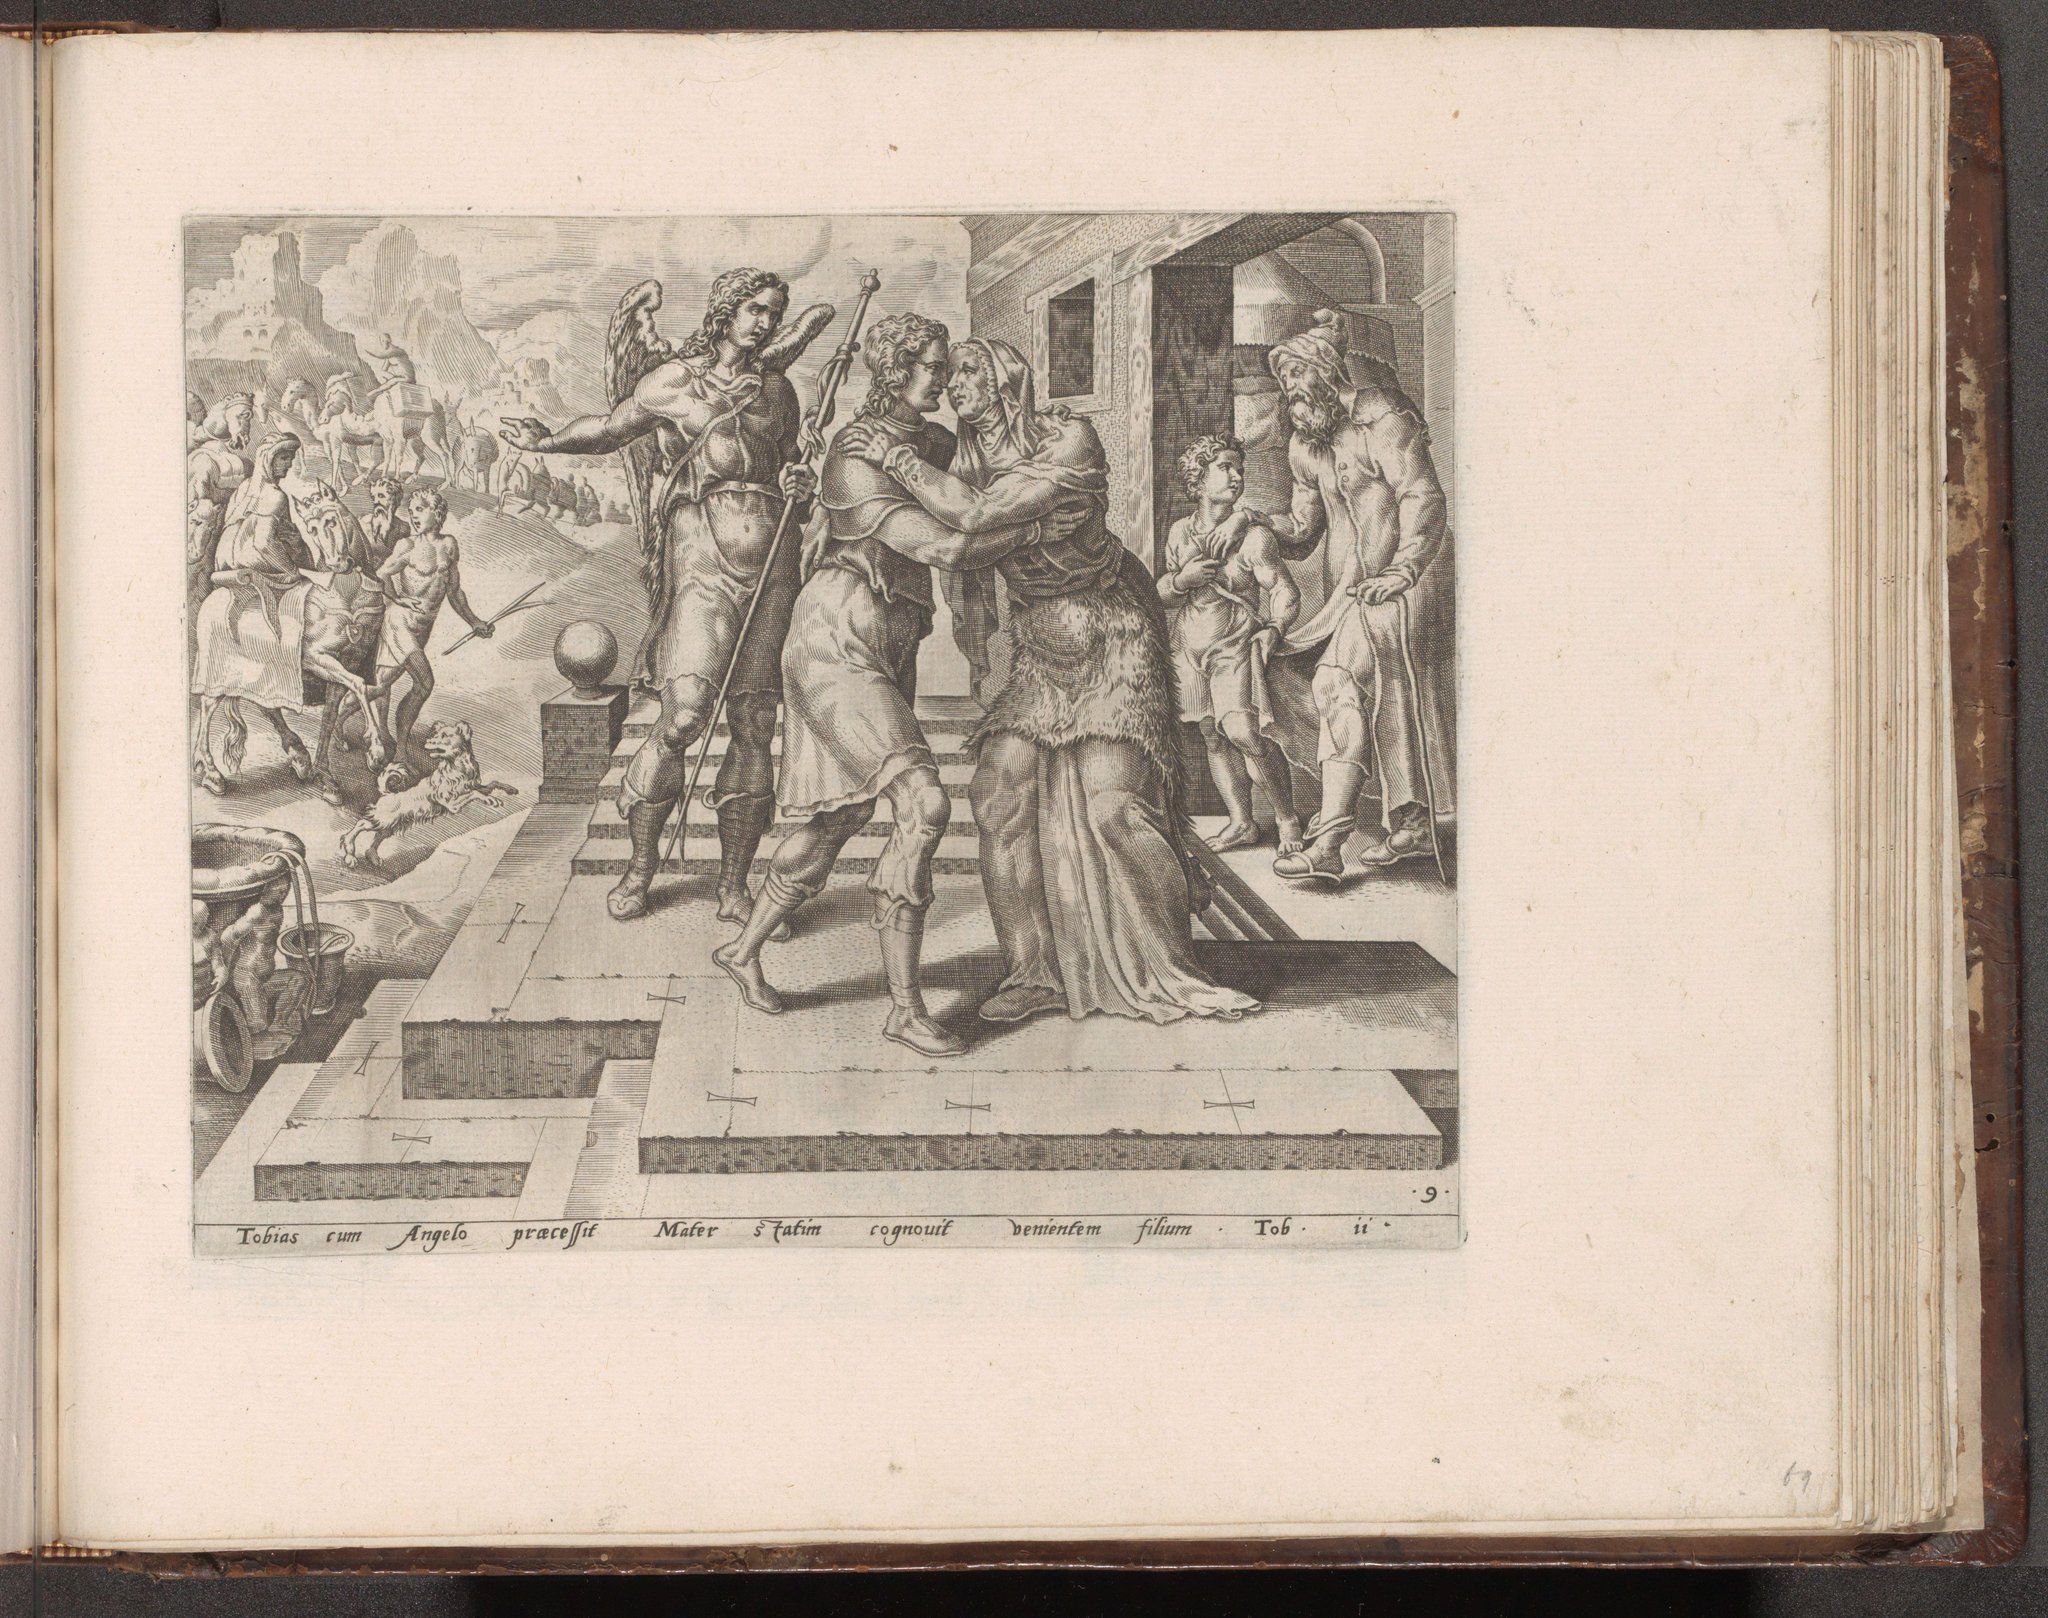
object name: print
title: Thesaurus sacrarum historiaru[m] veteris testame[n]ti, elega[n]tissimis imaginibus expressu[m] excelle[n]tissimoru[m] in hac arte viroru[m] opera: nu[n]c primu[m] in luce[m] editus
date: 1556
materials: paper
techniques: engraving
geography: antwerp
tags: the meeting of parents and son ~ tobias' return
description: Tobias omhelst zijn moeder Anna bij thuiskomst. Achter haar leidt een jongen de blinde Tobit naar buiten. De aartsengel Rafaël wijst in de richting van Sara en de met geschenken bepakte dieren. Onder de voorstelling een verwijzing naar de Bijbeltekst in Tobit 11 in het Latijn. Prent maakt deel uit van een album.